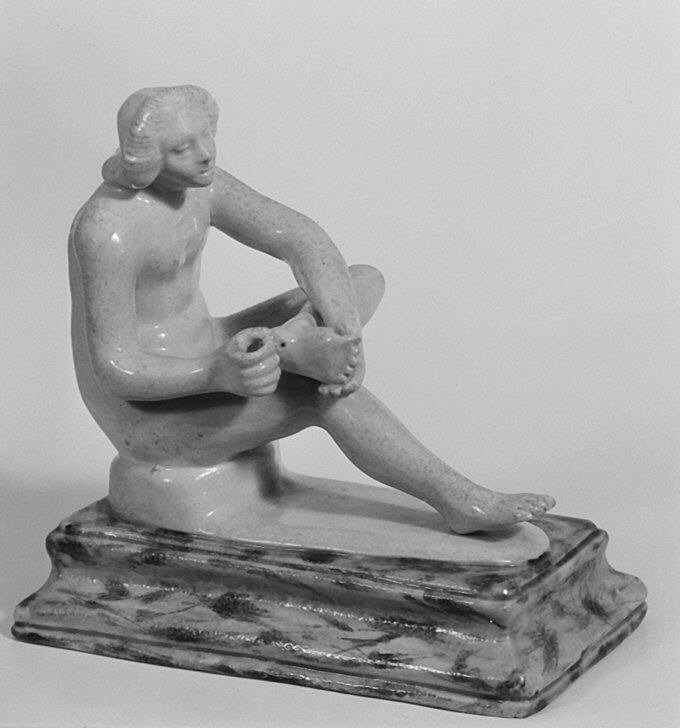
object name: figure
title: Spinario (Boy Pulling a Thorn from His Foot)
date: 1755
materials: stoneware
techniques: salt glaze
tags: boys